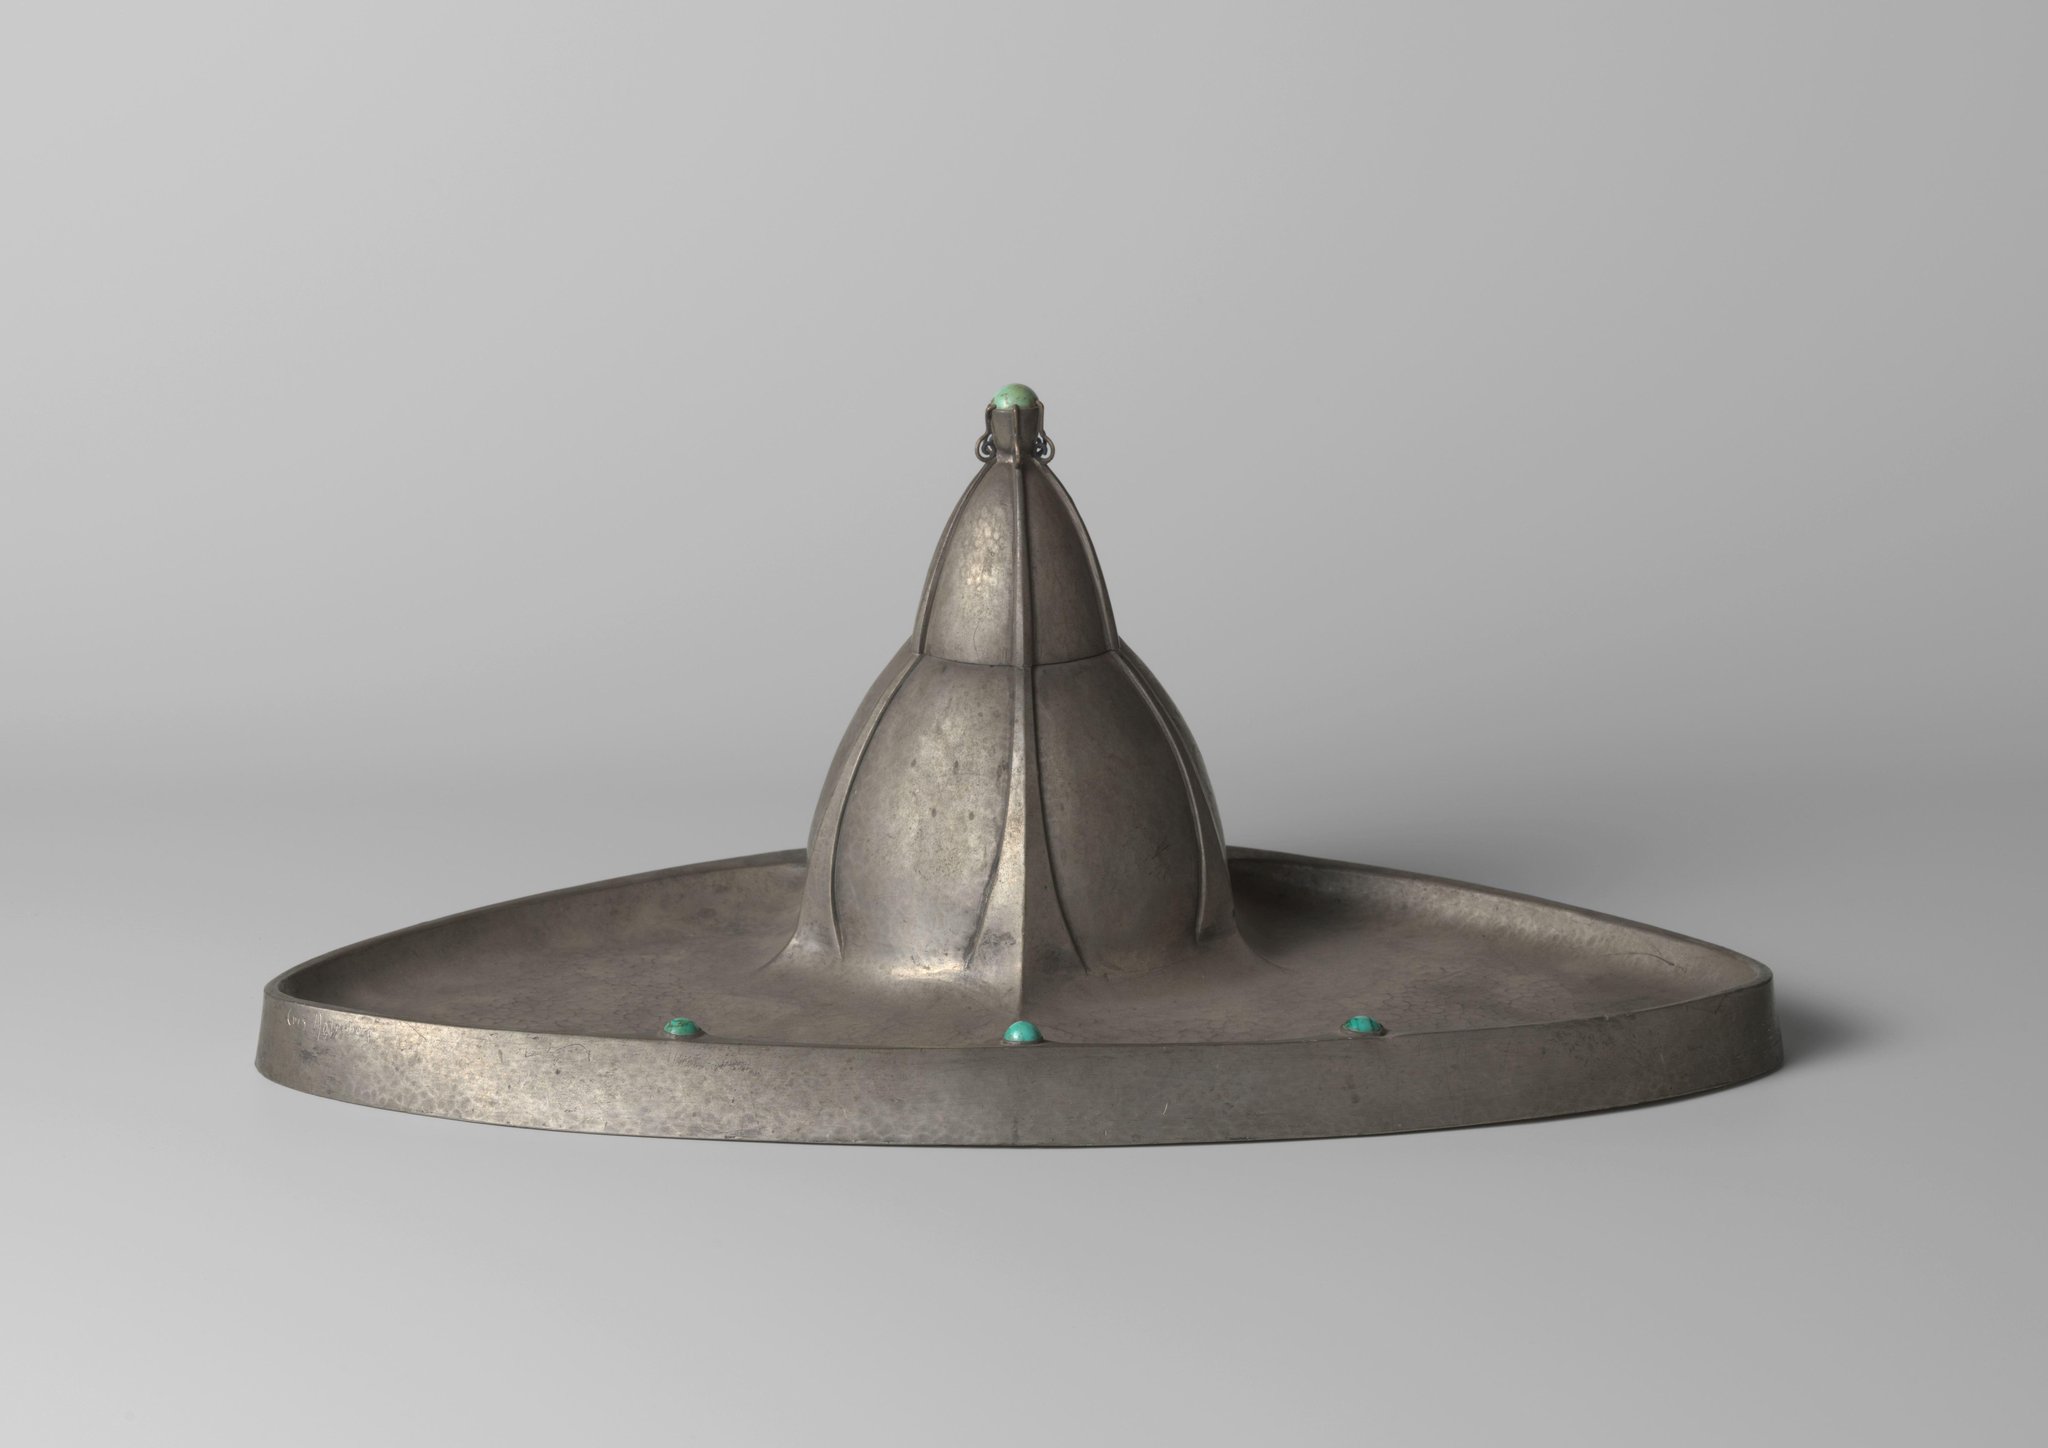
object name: inkstand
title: Inktstel van tin, langs de rand van de pennenbak en op het deksel van de inktpot ingelegd met groene stenen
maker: chris agterberg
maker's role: print maker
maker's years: 1883-1948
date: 1910-1930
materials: tin, gemstone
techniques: repoussé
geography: netherlands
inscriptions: inscription: ‘7234’, inscription: ‘Cris Agterberg’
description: Inktstel van tin. De pennenbak is ovaal met de achterzijde ronder dan de voorzijde. De voorzijde is versierd met drie turkooise stenen. Tegen de achterzijde bevindt zich de ovale inktpot, die met een eenkakig scharnier wordt afgesloten met een omgekeerd conische deksel eindigend in een dop met turquoise steen. De buitenzijde van de inktpot en deksel is versierd met vijf verticaal opgelegde banden. De dop heeft aan de buitenzijde vijf voluten. In de inktpot is een kleine, losse binnenbak geplaatst.